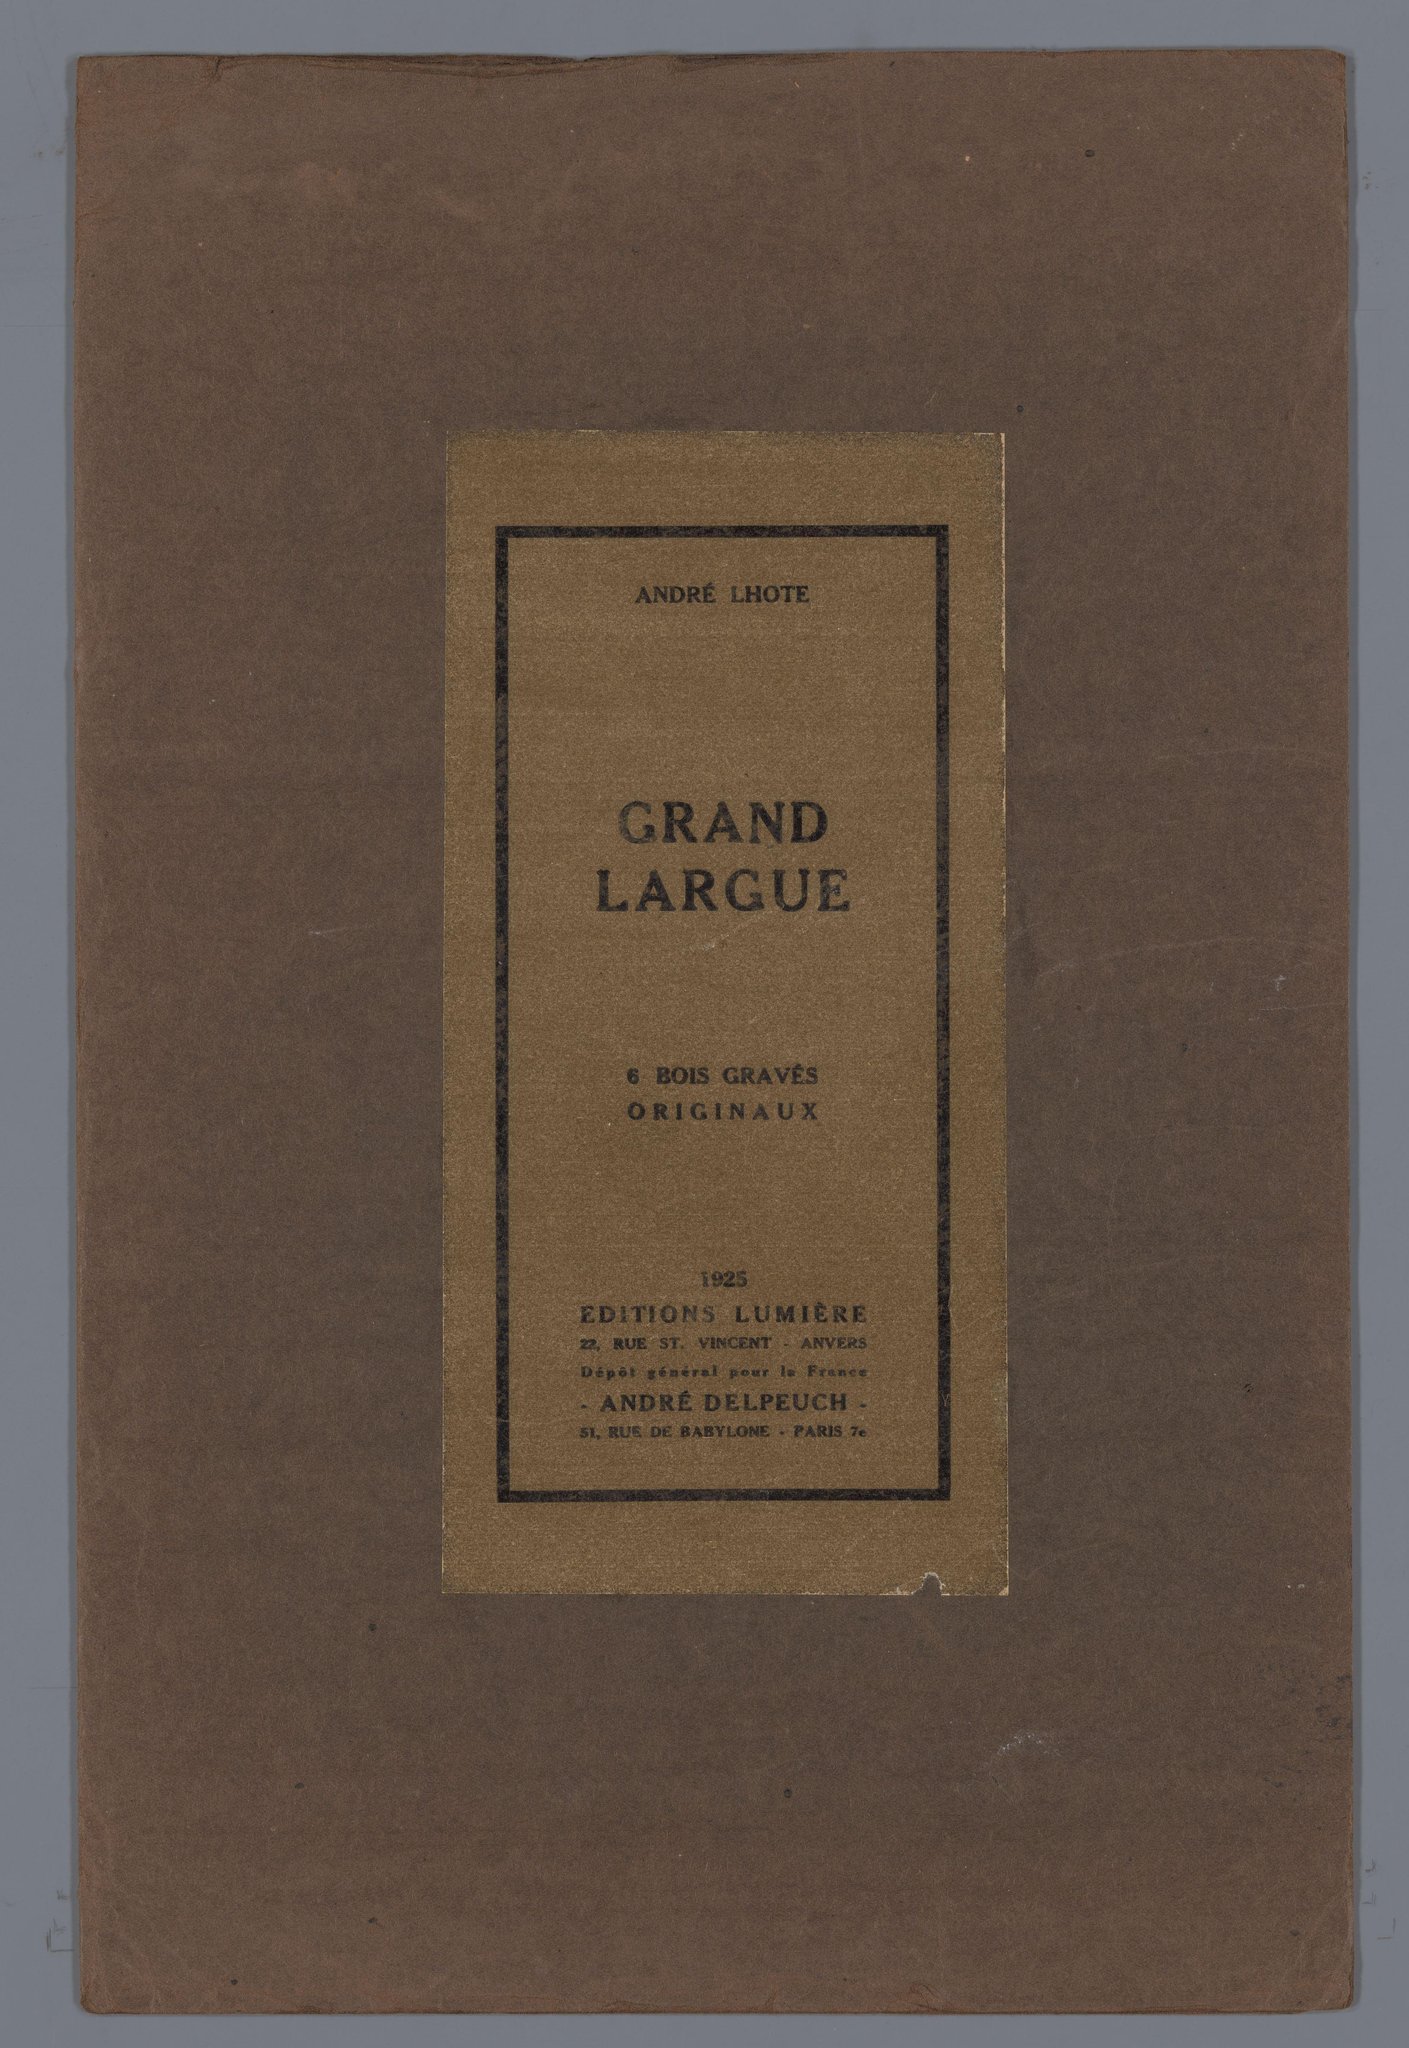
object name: wrapper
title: Zes houtsnedes met maritieme scènes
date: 1925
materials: paper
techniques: letterpress printing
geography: paris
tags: merman - aa - mermaid, siren, accordion, inn, coffee-house, public house, etc., sailor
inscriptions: collector's mark: Lugt 2228, collector's mark: Lugt 2760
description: In deze omslag bevindt zich een zesdelige serie prenten met als onderwerp de zee en het leven van zeemannen, gemaakt door André Lhote.